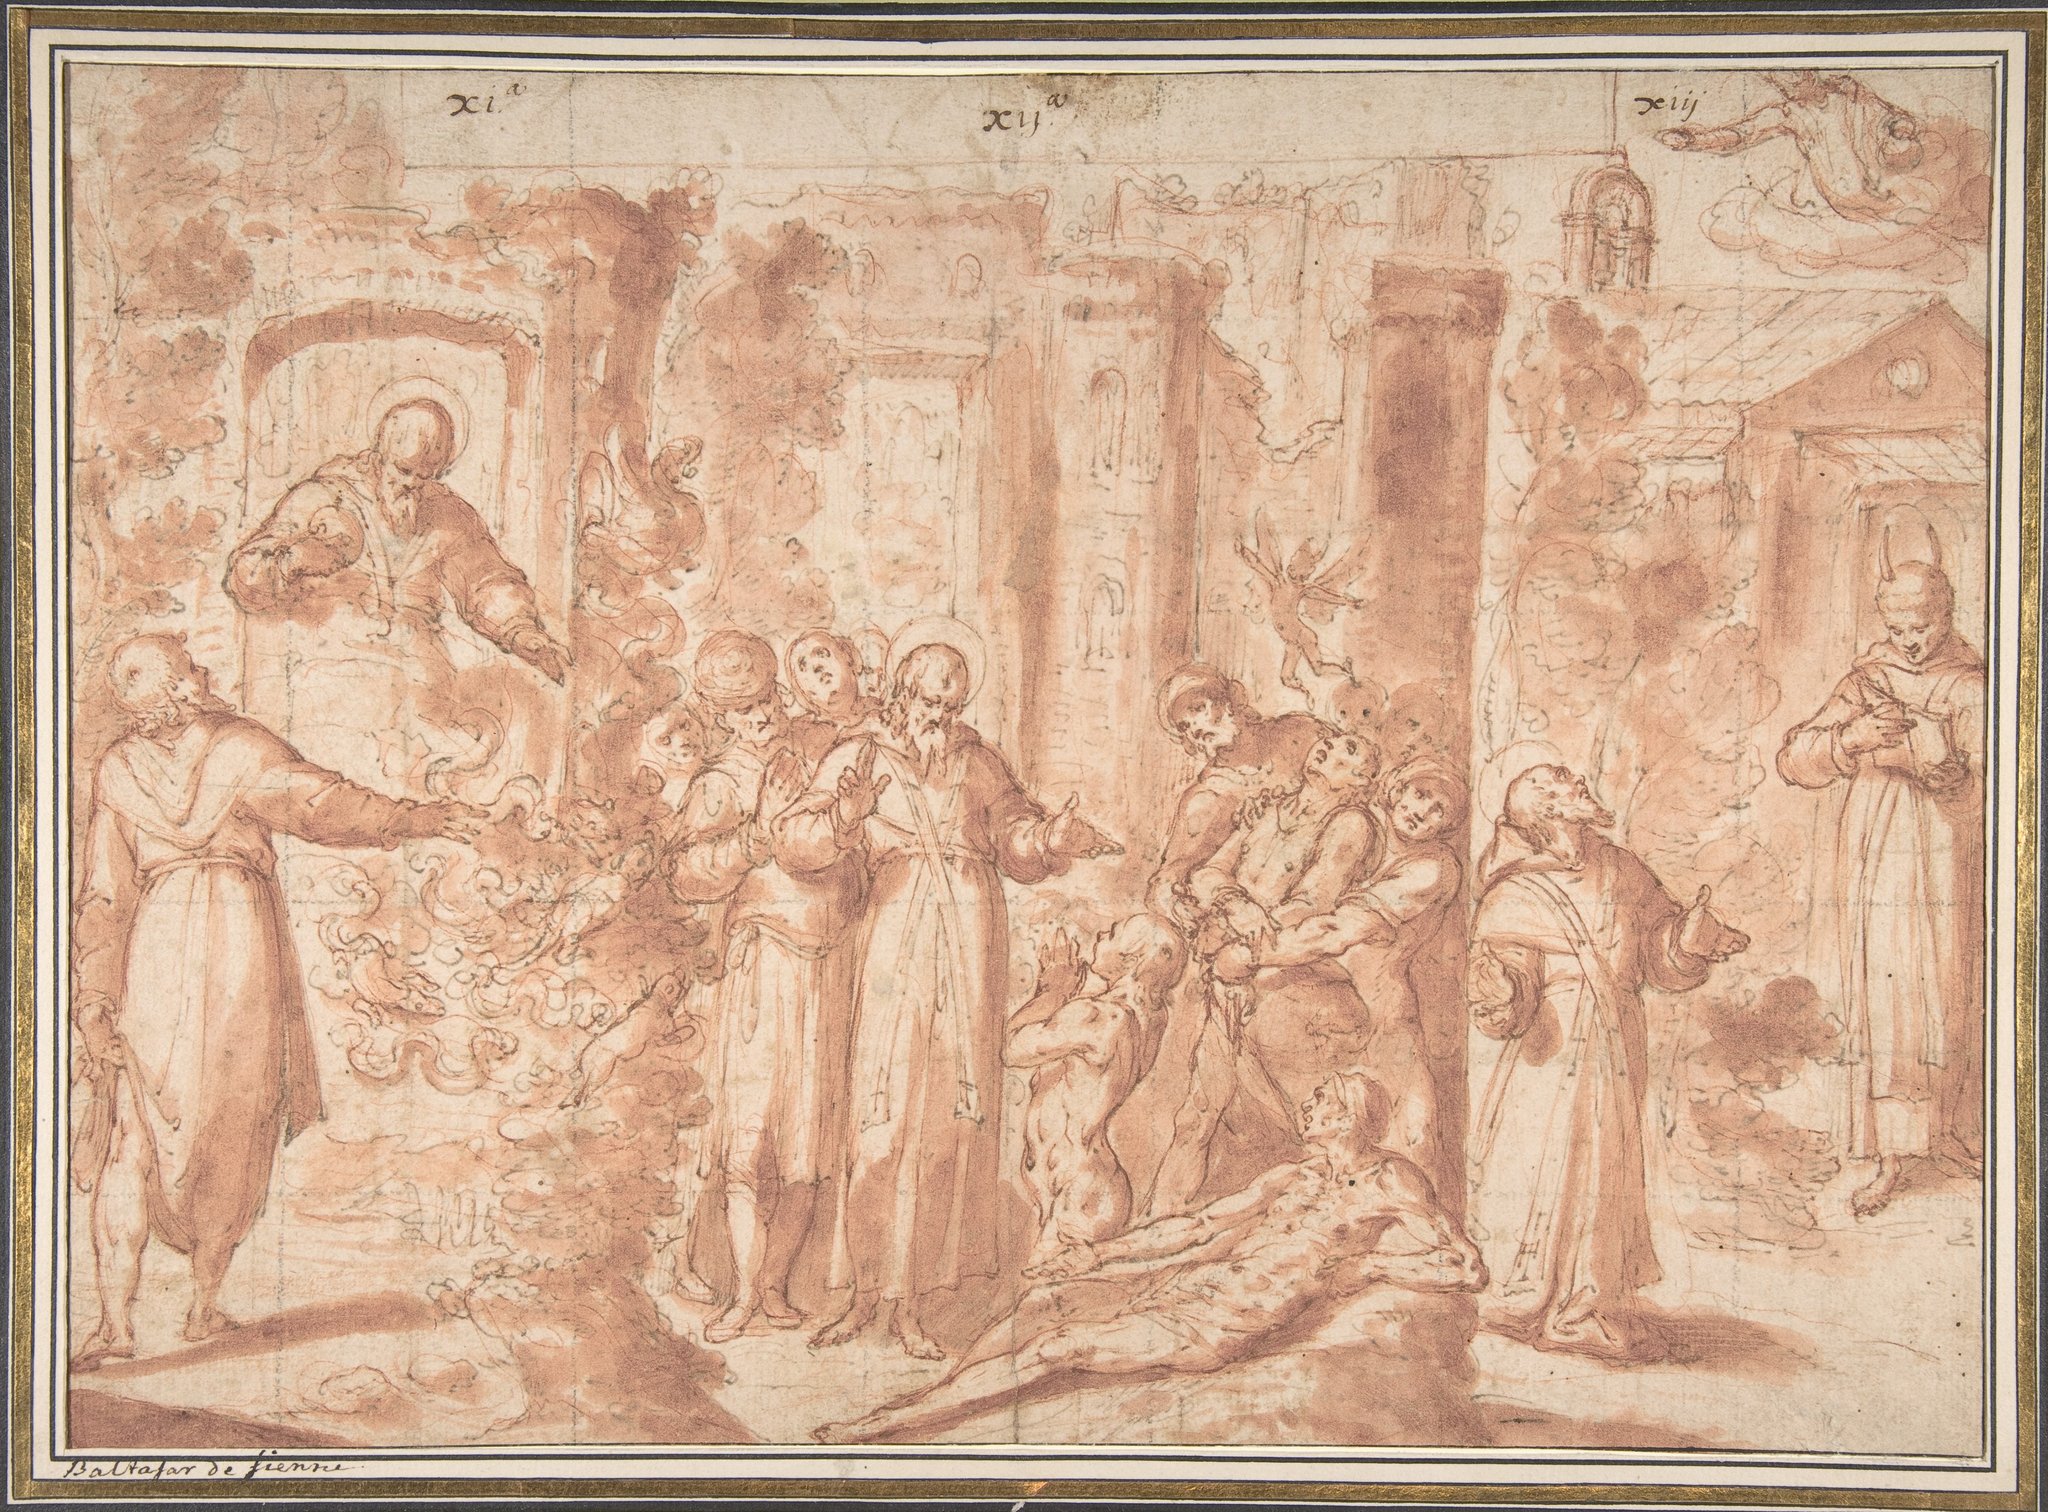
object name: drawing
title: Scenes from the Life of Saint Anthony Abbot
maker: giovanni battista lombardelli (giovanni battista della marca, "il montano")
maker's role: artist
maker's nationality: italian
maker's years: 1532-1587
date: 1532-1587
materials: chalk, ink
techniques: brush, pen, wash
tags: men,saints